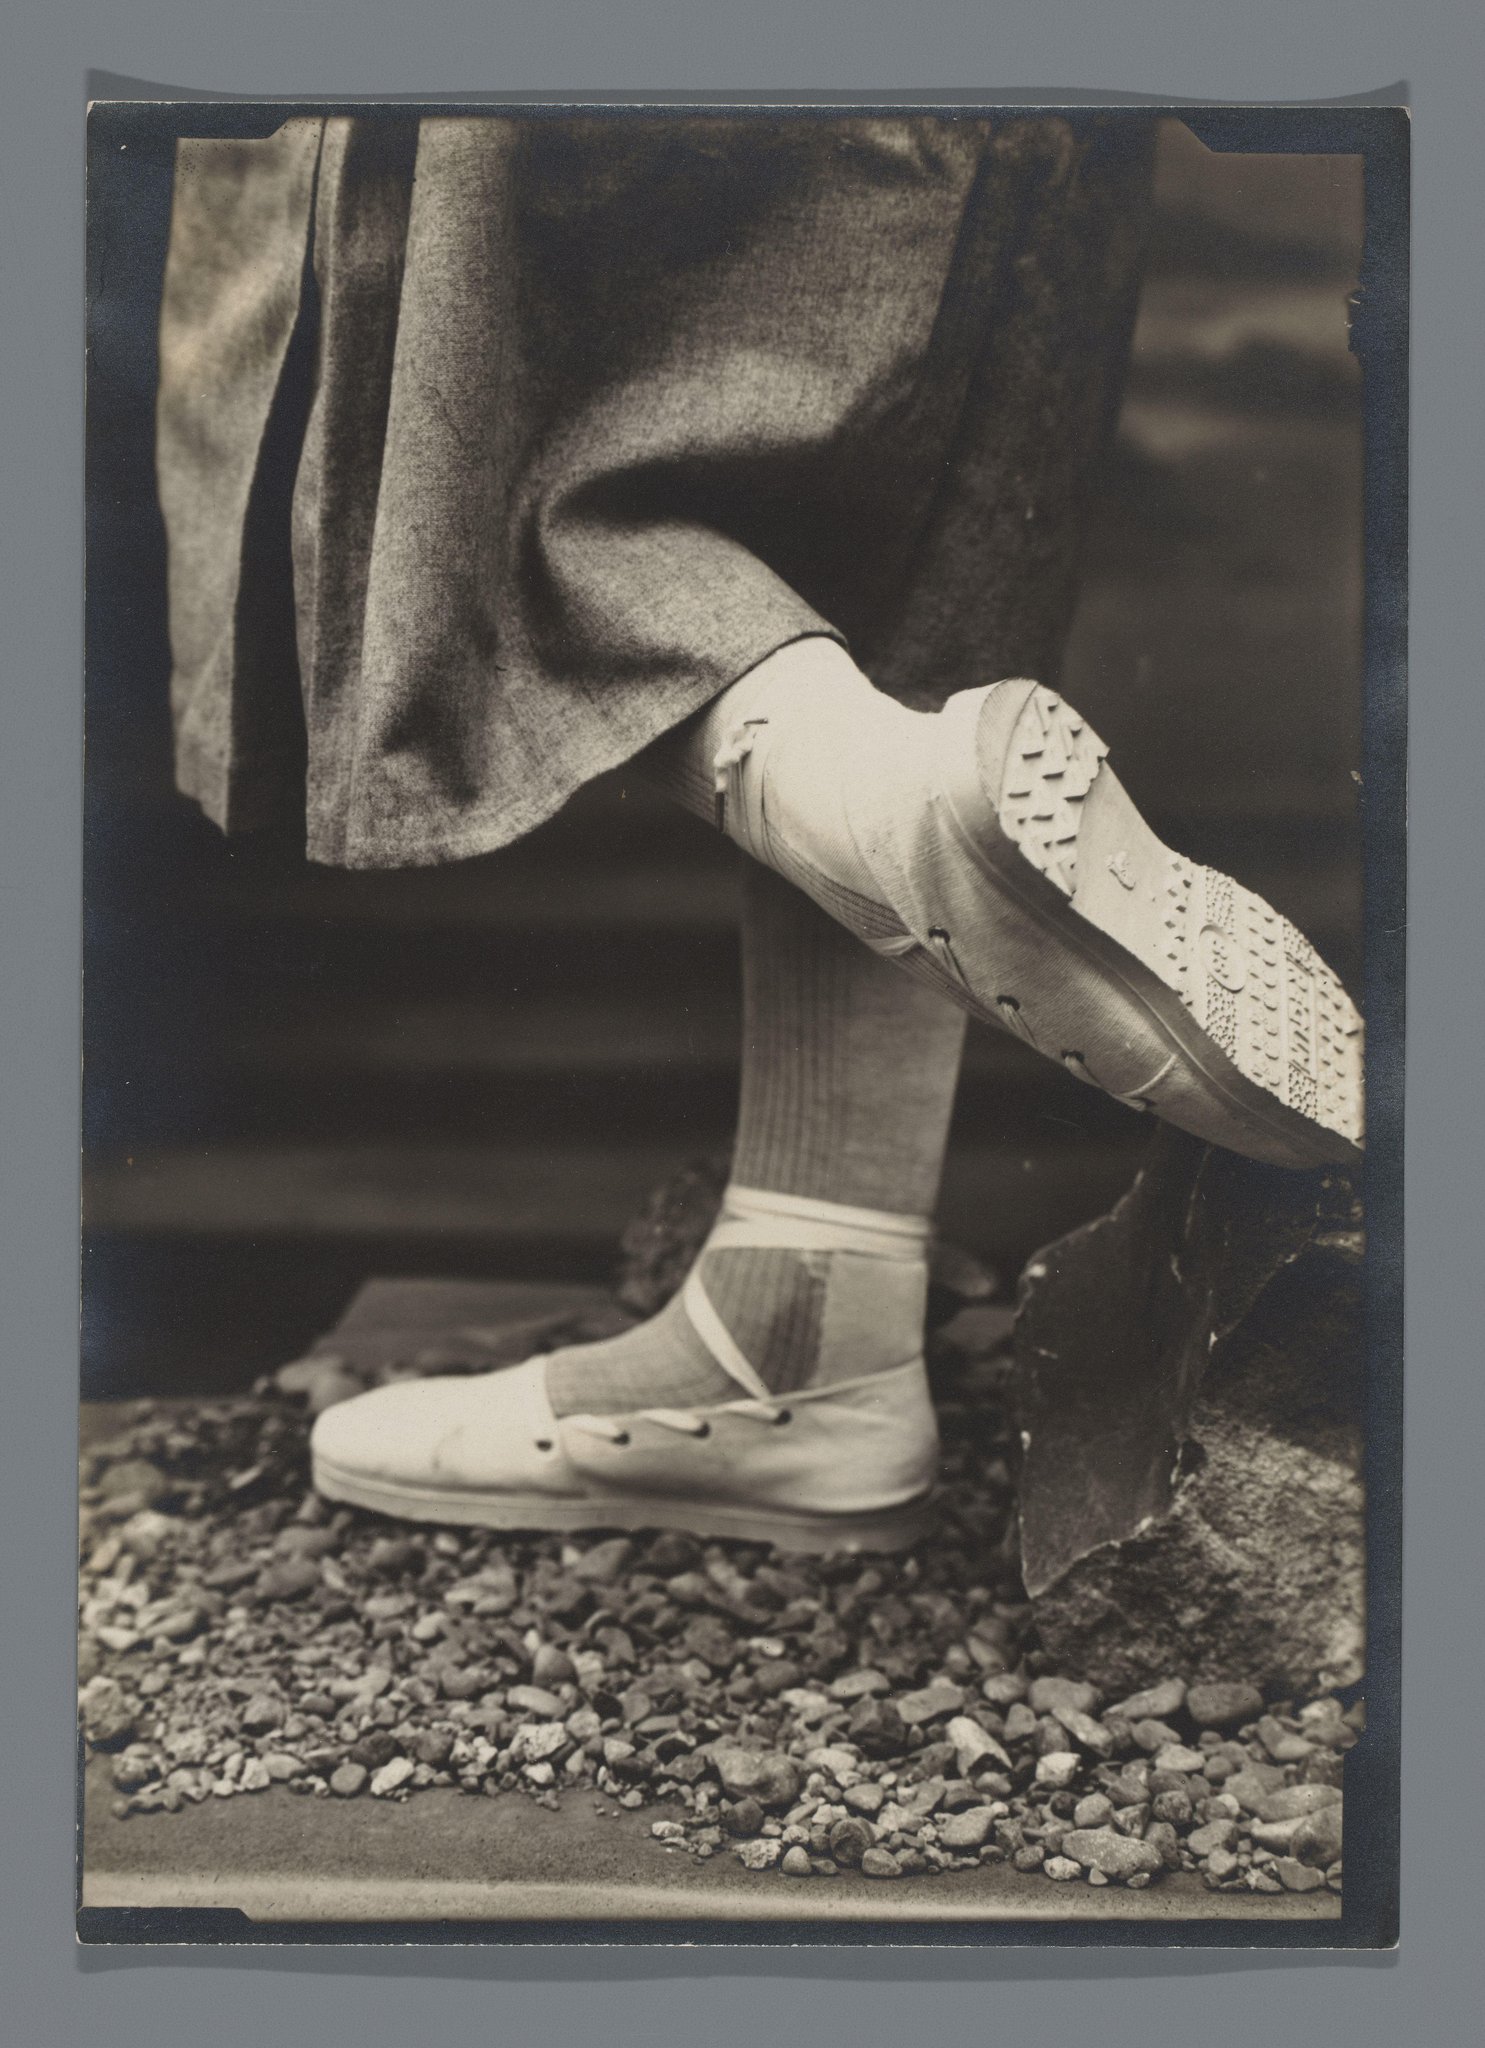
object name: photograph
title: Schoenmode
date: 1930-1935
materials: photographic support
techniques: gelatin silver print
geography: paris